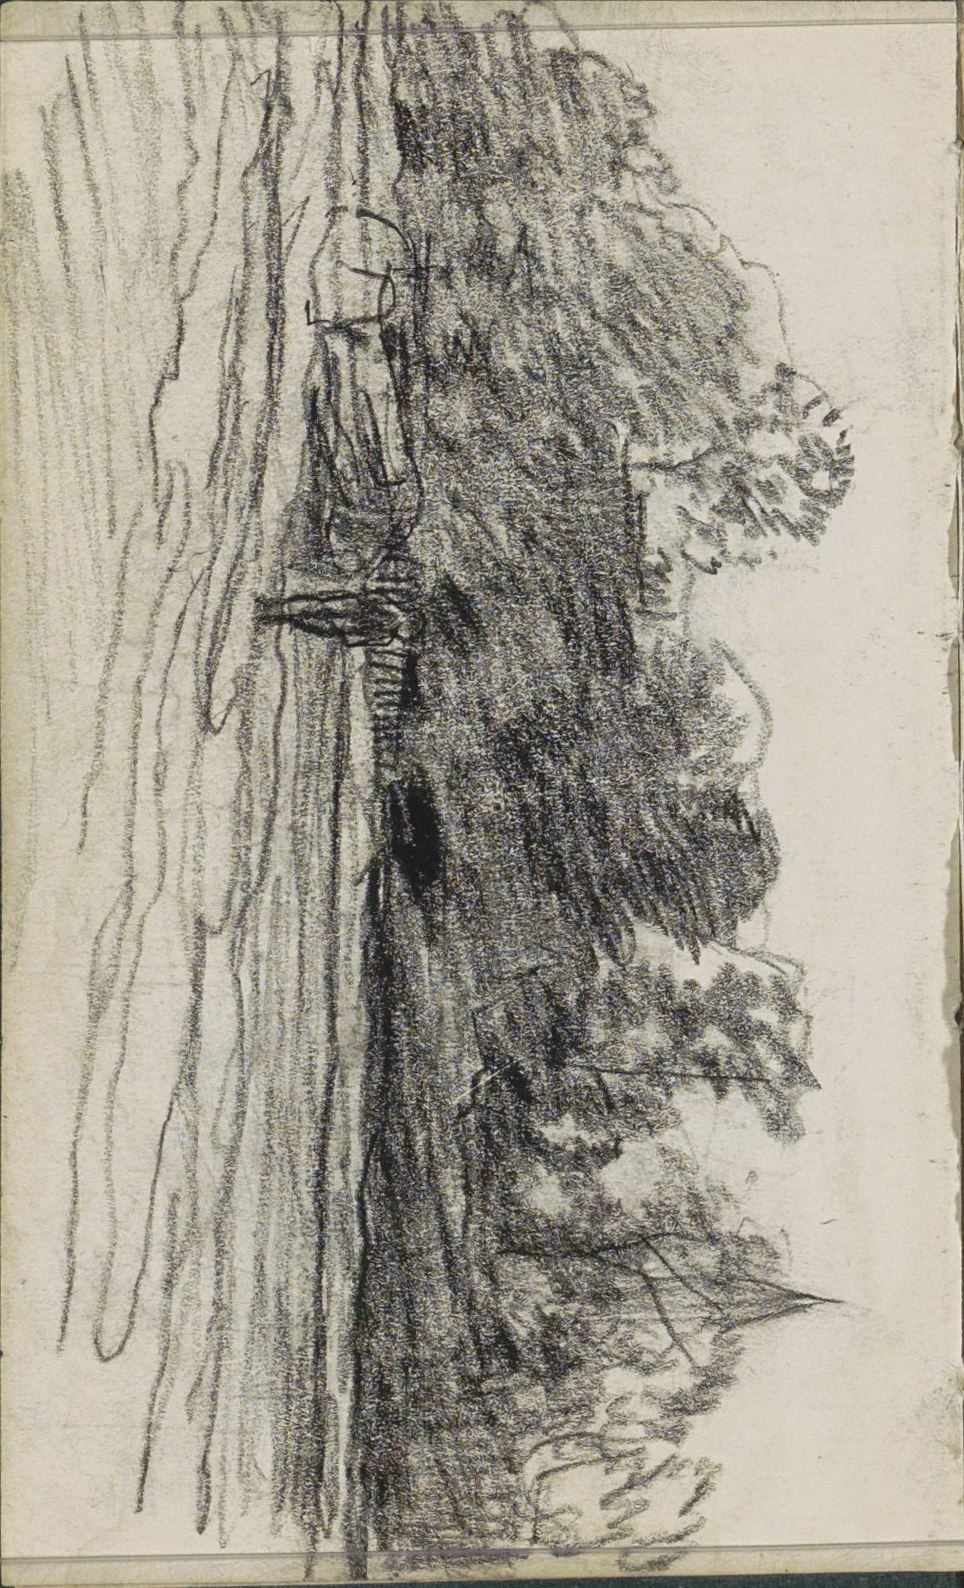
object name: sketchbook leaf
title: Geploegd veld naast een groep bomen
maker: anton mauve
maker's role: draughtsman, painter, print maker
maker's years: 1838-1888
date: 1848-1888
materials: chalk, paper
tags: ploughed field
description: In het veld staat een een figuur of een paard. Blad 1 verso uit een schetsboek met 53 bladen.